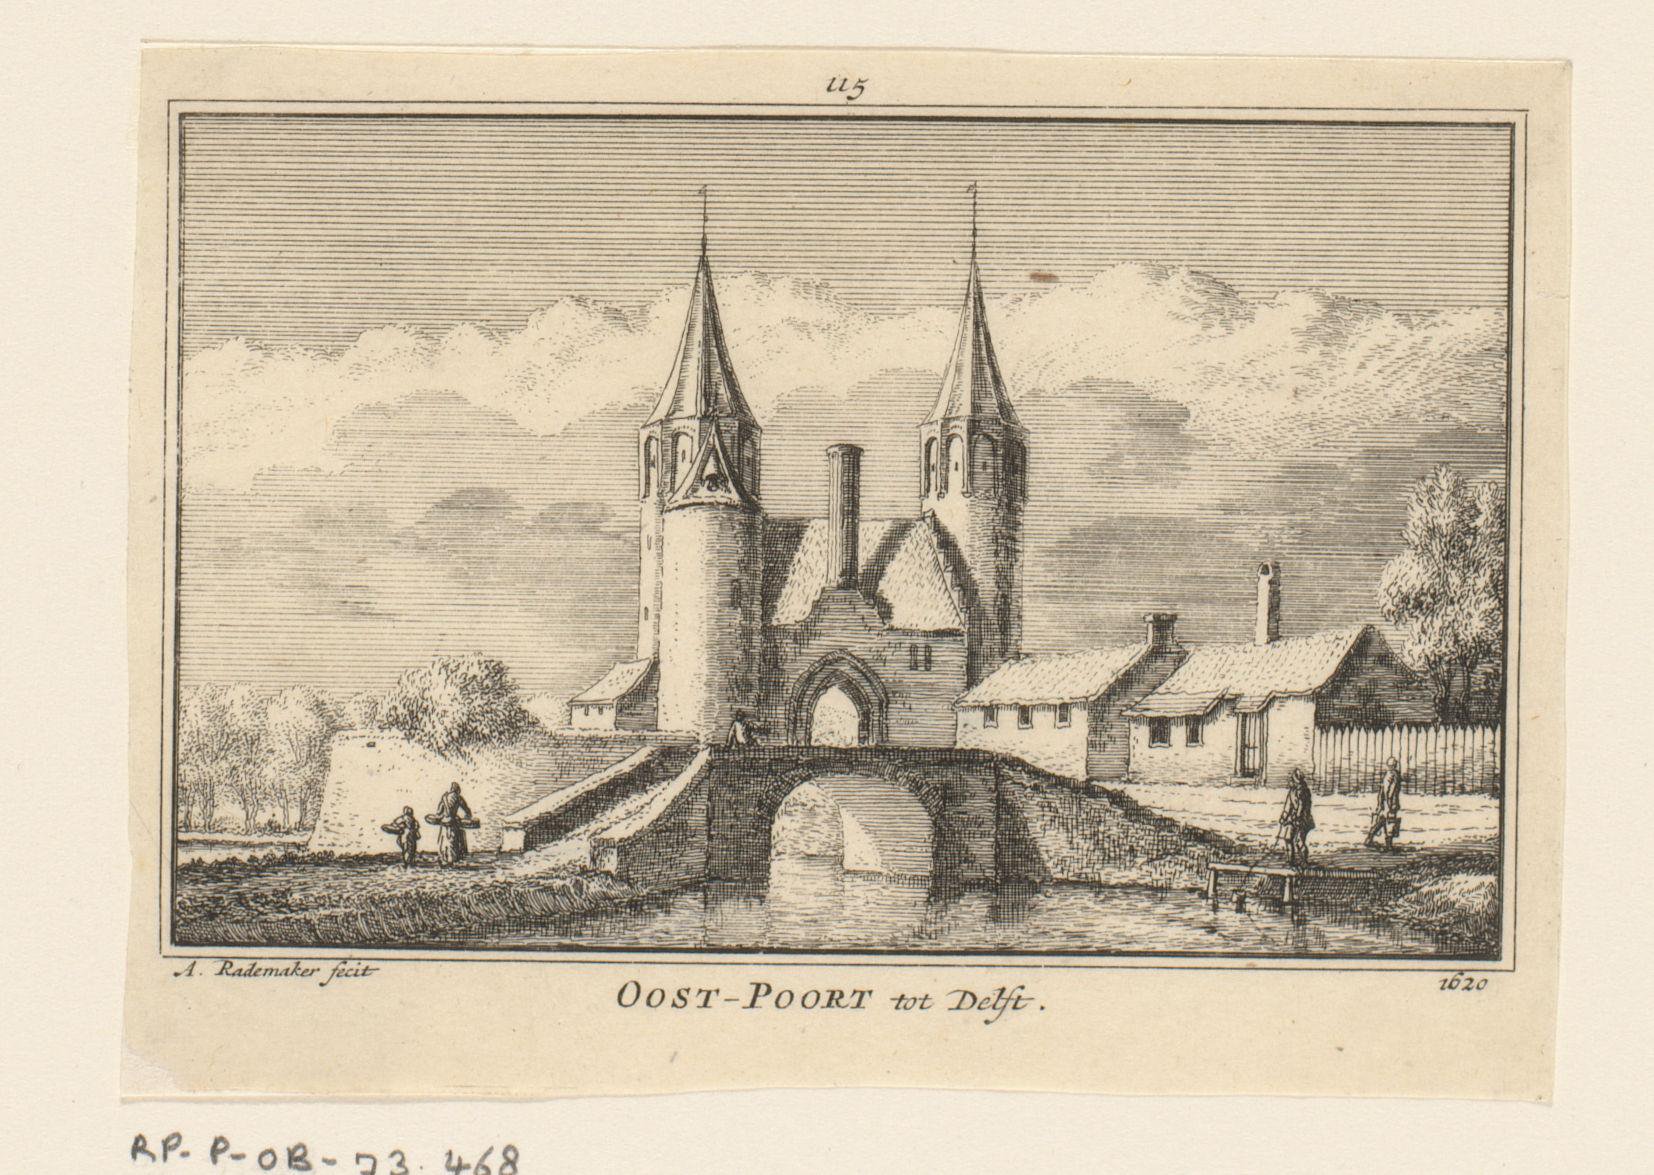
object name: book illustration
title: Gezicht op de Oostpoort te Delft, 1620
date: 1727-1733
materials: paper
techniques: etching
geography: amsterdam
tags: city-gate, fisherman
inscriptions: collector's mark: Lugt 2228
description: Illustratie uit: Abraham Rademaker, Matthaeus Brouërius van Niedek, Isaac Le Long, Kabinet van Nederlandsche en Kleefsche outheden en (...) voorname stads- en landgebouwen, Willem Barents en Antoni Schoonenburg: Amsterdam, 1727-1733, ill. nr. 115.